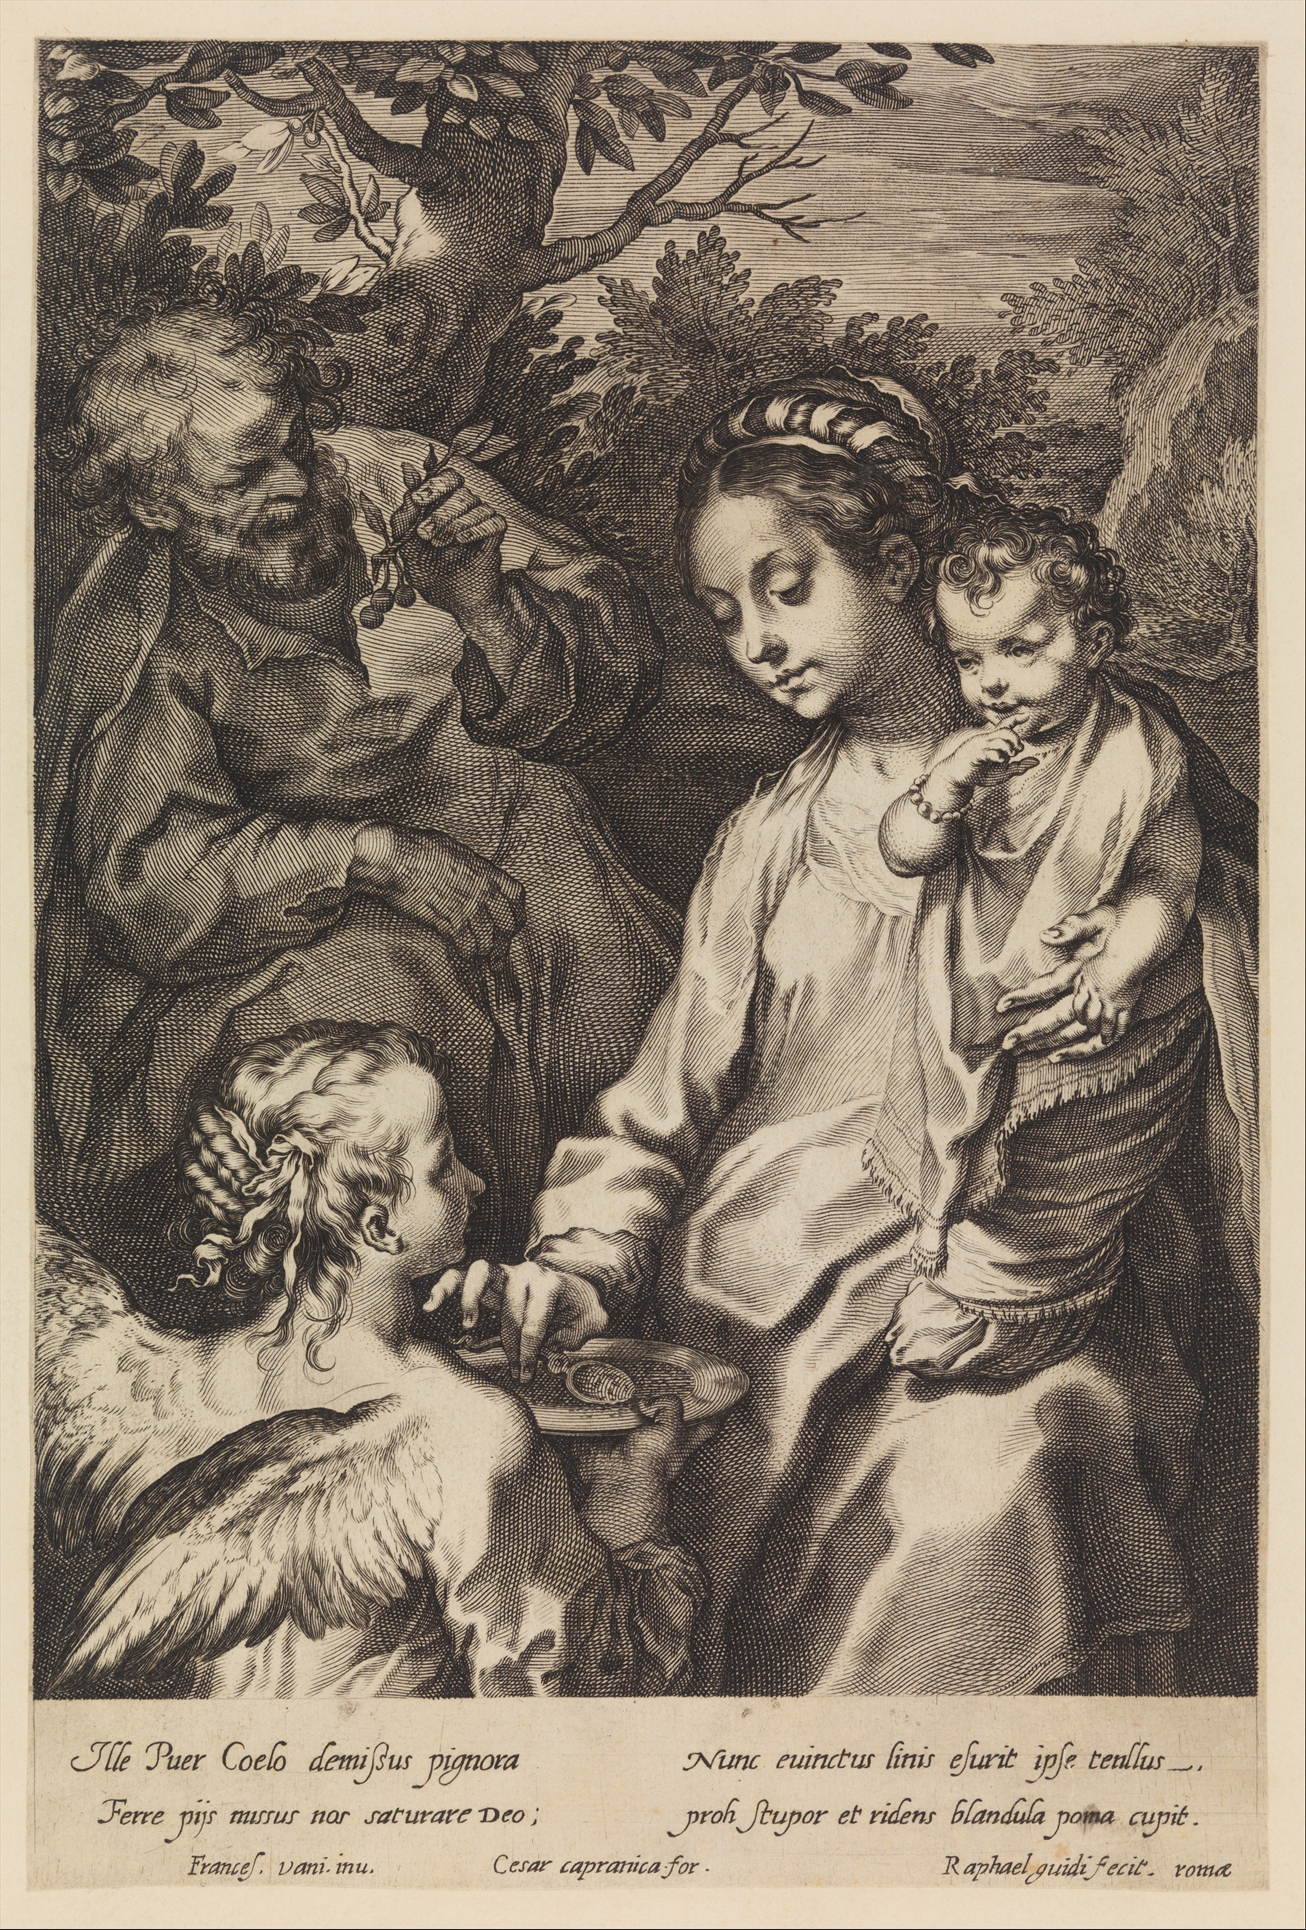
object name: print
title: The Holy Family with the Porridge Bowl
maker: raffaello guidi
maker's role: artist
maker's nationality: italian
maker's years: 1585-1615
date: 1580-1614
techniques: engraving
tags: holy family,bowls